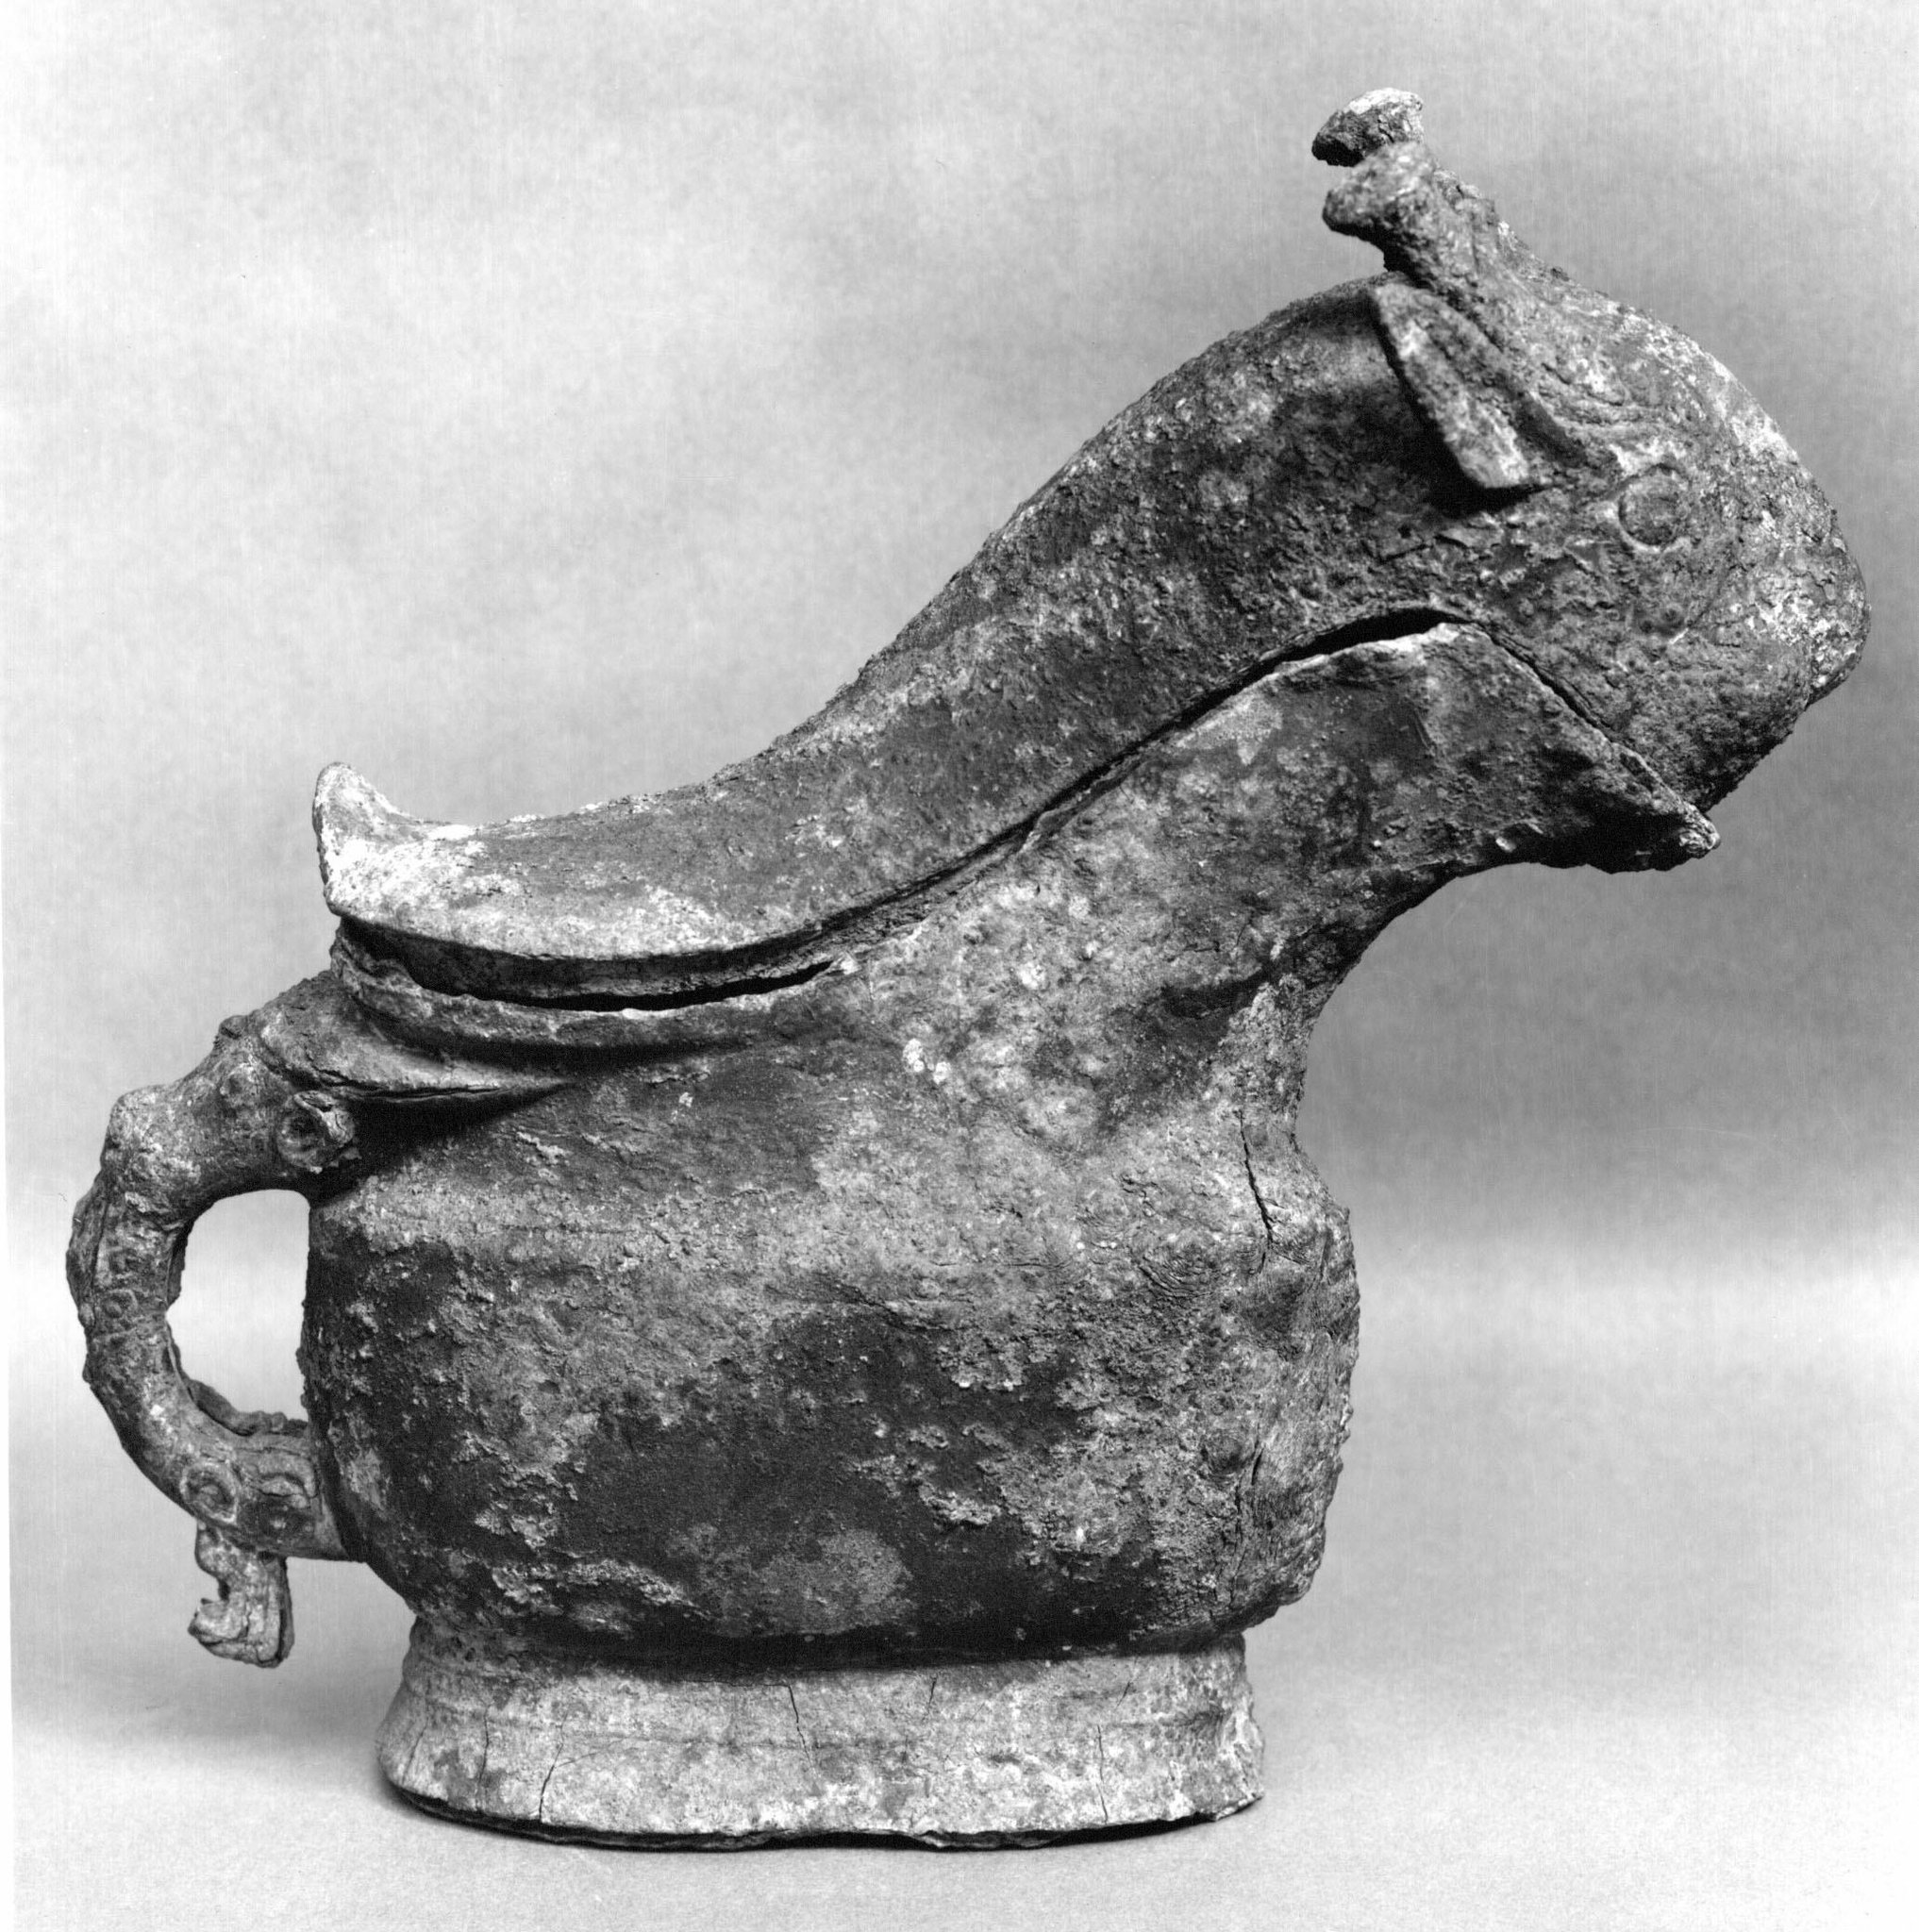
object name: wine vessel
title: Wine Pouring Vessel (Gong)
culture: chinese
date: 1300-1201 BCE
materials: bronze